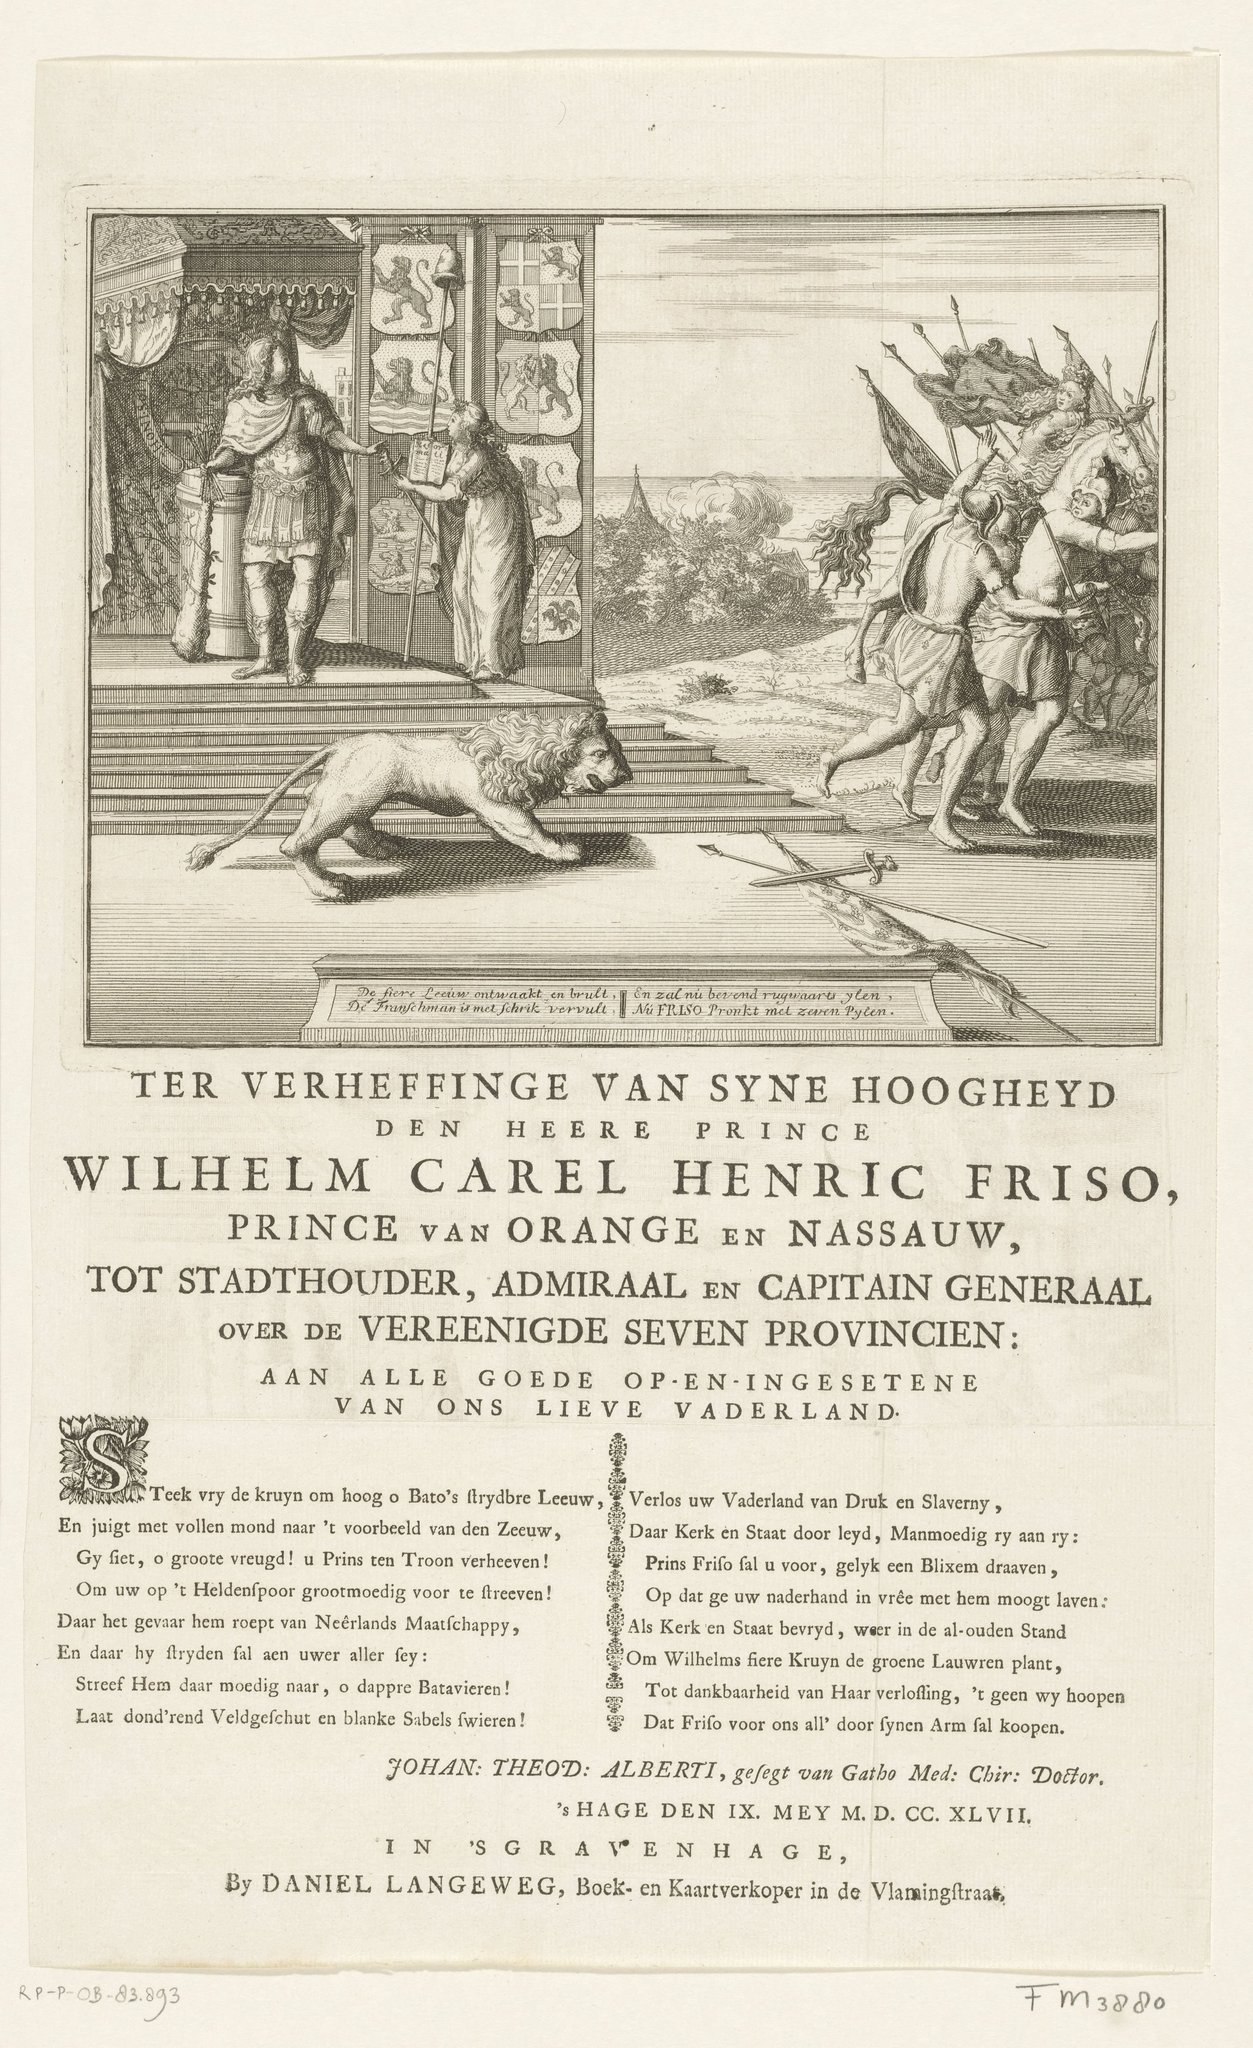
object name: print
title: Allegorie op de verheffing van Willem IV, 1747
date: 1747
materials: paper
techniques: engraving, etching, letterpress printing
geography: the hague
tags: willem iv (prins van oranje-nassau), personifications of countries, nations, states, districts, etc., netherlands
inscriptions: collector's mark: Lugt 2228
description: Allegorie op de verheffing van Willem IV tot stadhouder van de Republiek, mei 1747. De Nederlandse Maagd overhandigt het zwaard aan stadhouder Willem IV bij een altaar. Op de voorgrond verjaagt de Nederlandse Leeuw de vijanden van de Republiek, de Fransen. Op het blad onder de plaat een vers in twee kolommen.